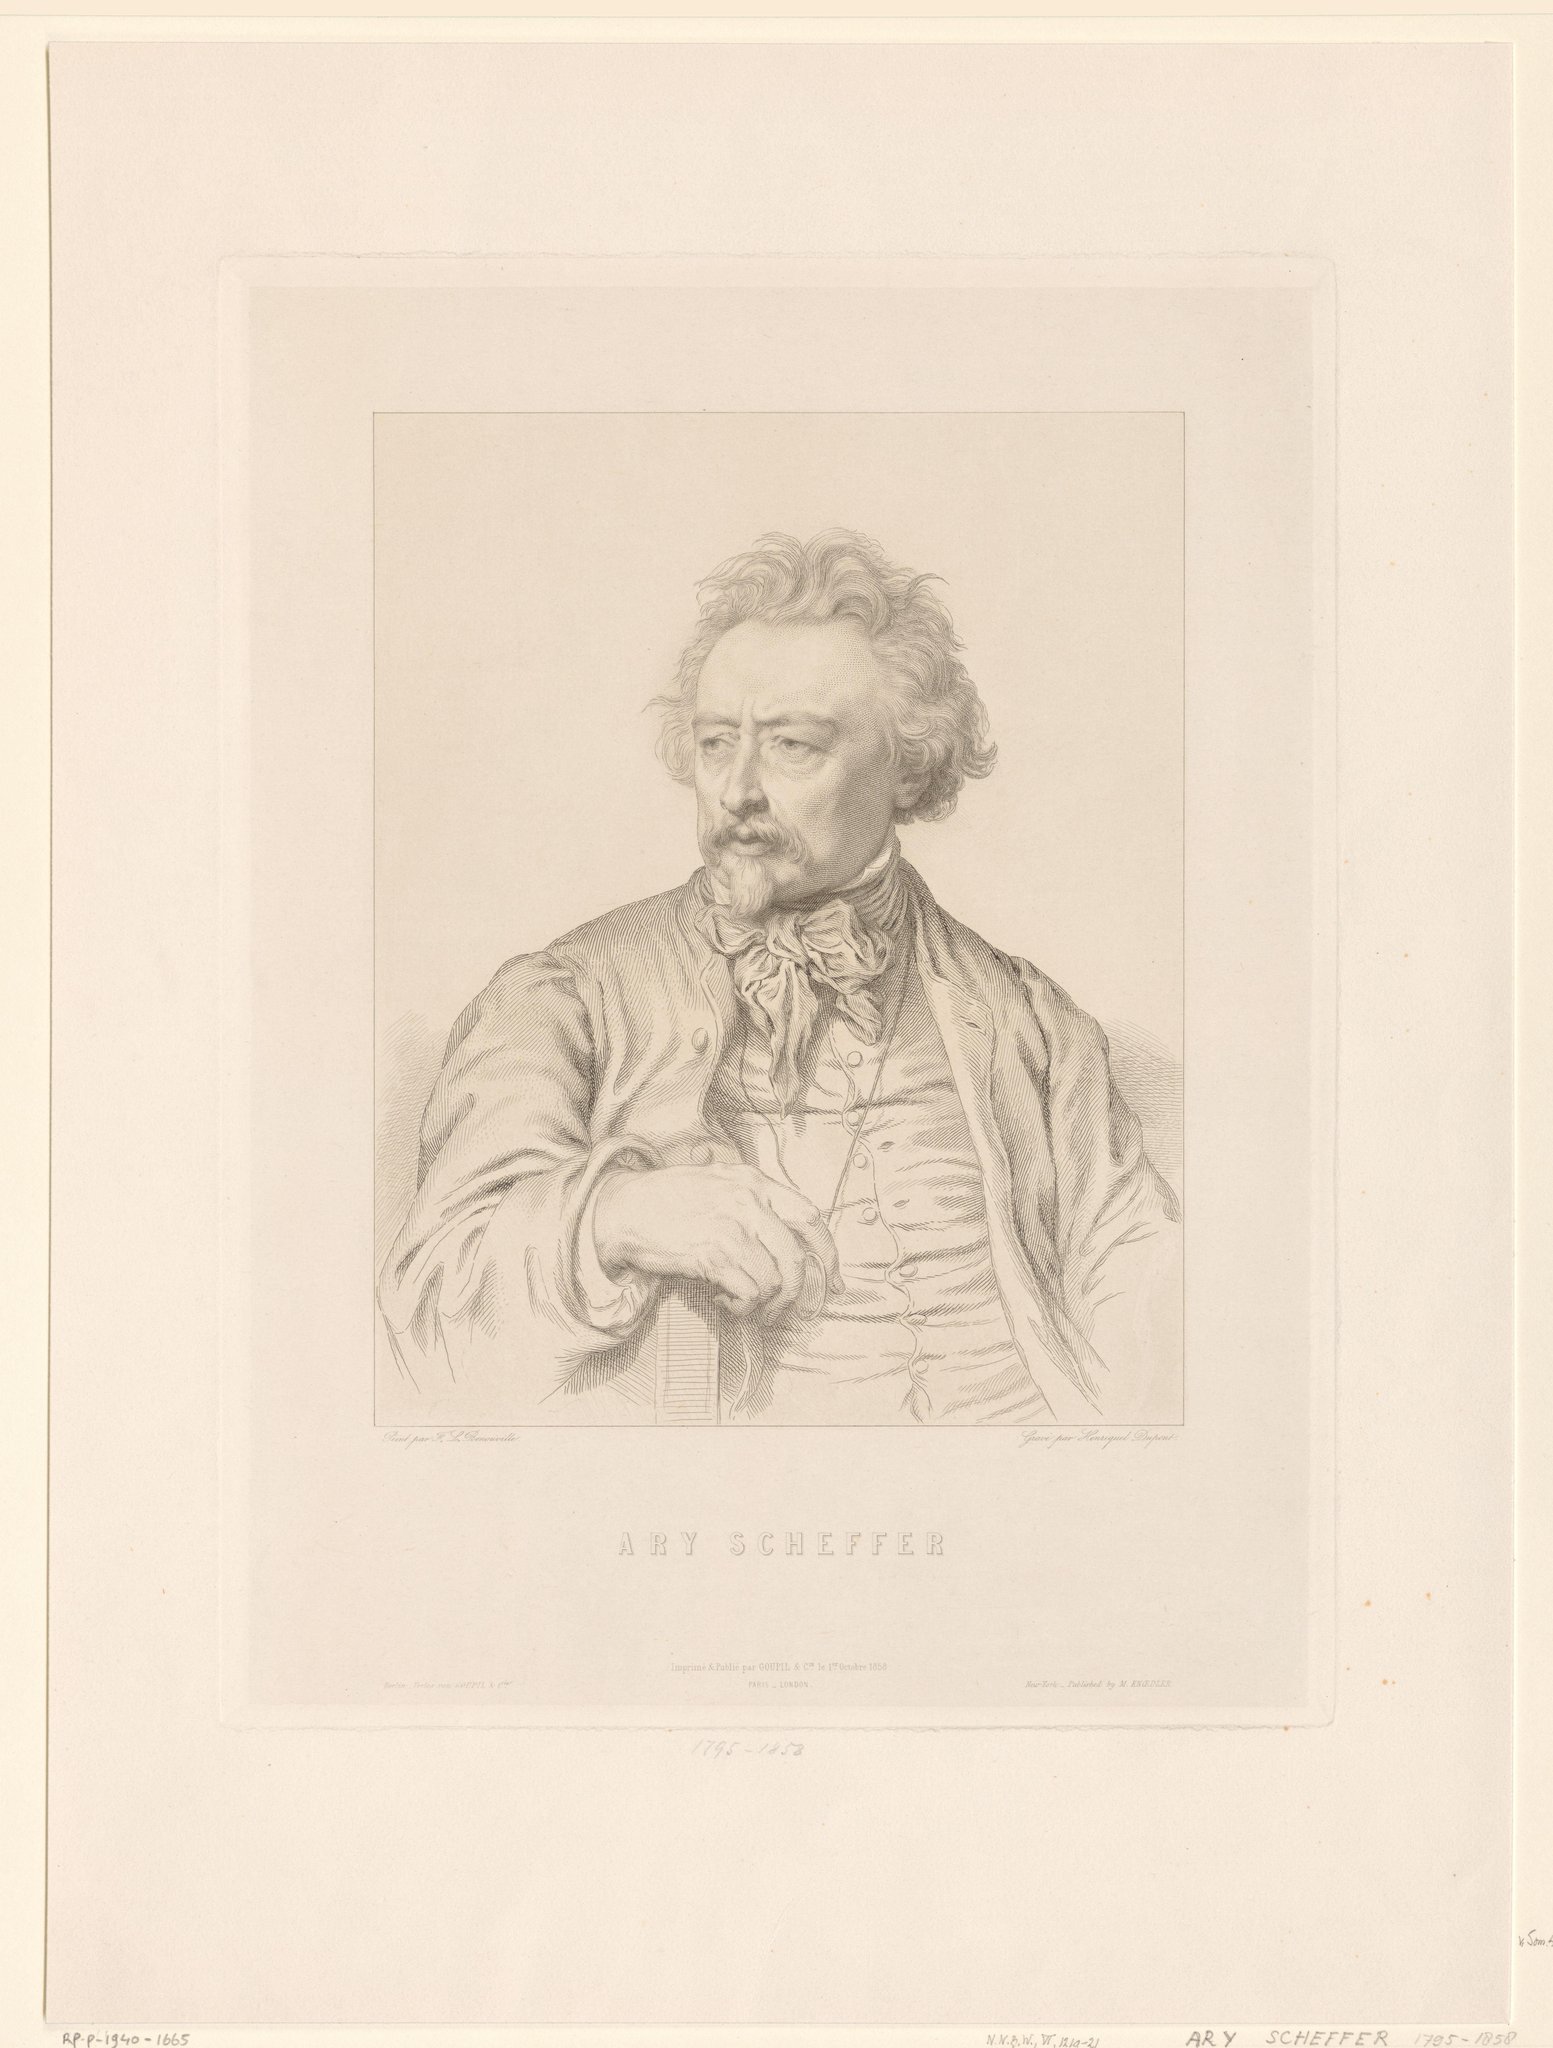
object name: print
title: Portret van Ary Scheffer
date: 1858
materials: paper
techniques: engraving, etching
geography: new york city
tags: dordrecht, painter, print maker, draughtsman, sculptor, ary scheffer, adult man, historical persons, portrait, self-portrait of painter, tools, implements of painter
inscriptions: date